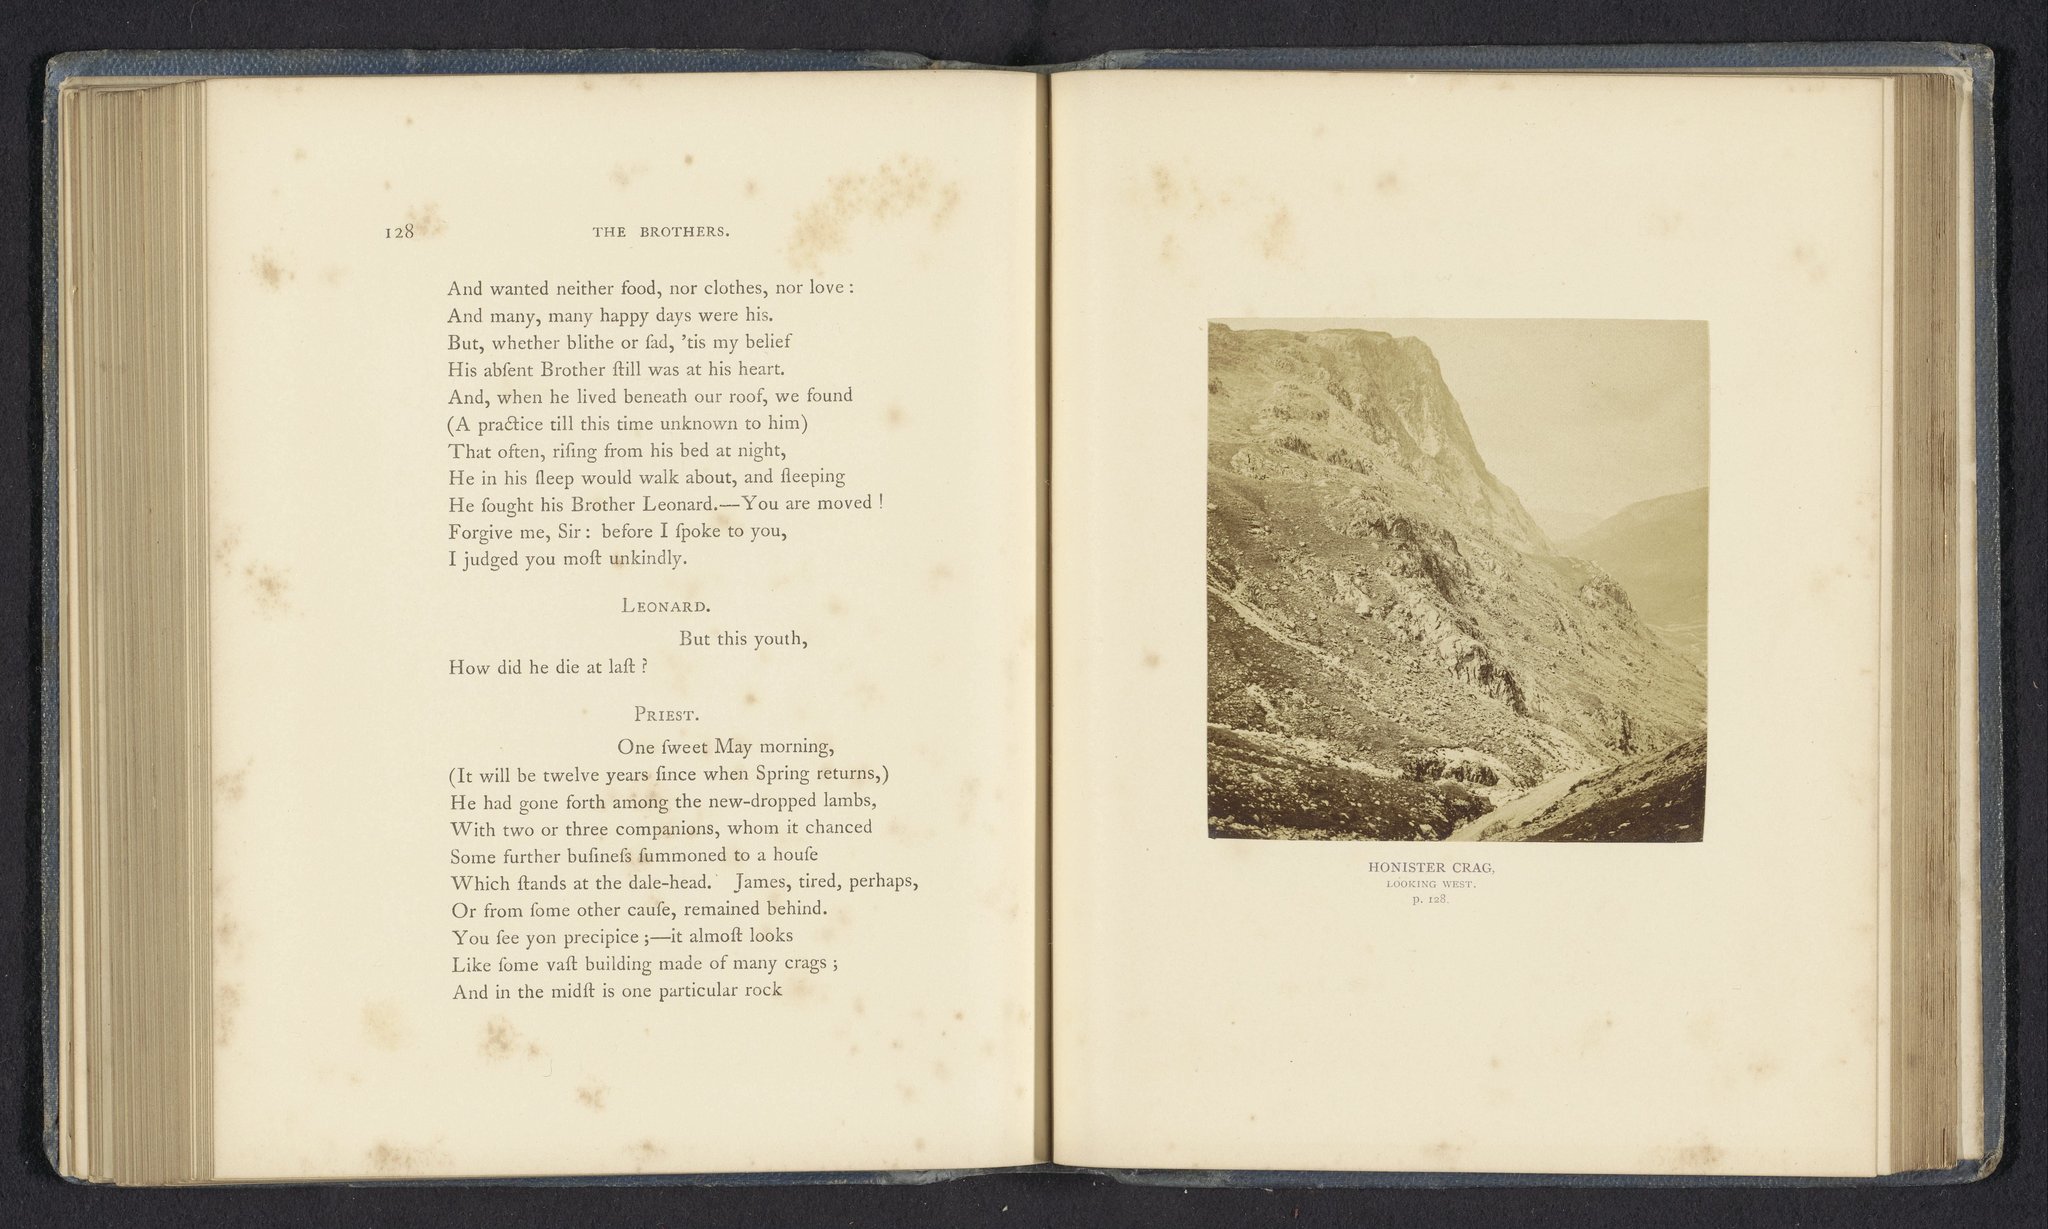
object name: photograph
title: Honister Crag, looking west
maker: thomas ogle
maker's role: fotograaf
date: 1854-1864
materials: photographic support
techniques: albumen print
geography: lake district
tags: low hill country, public road